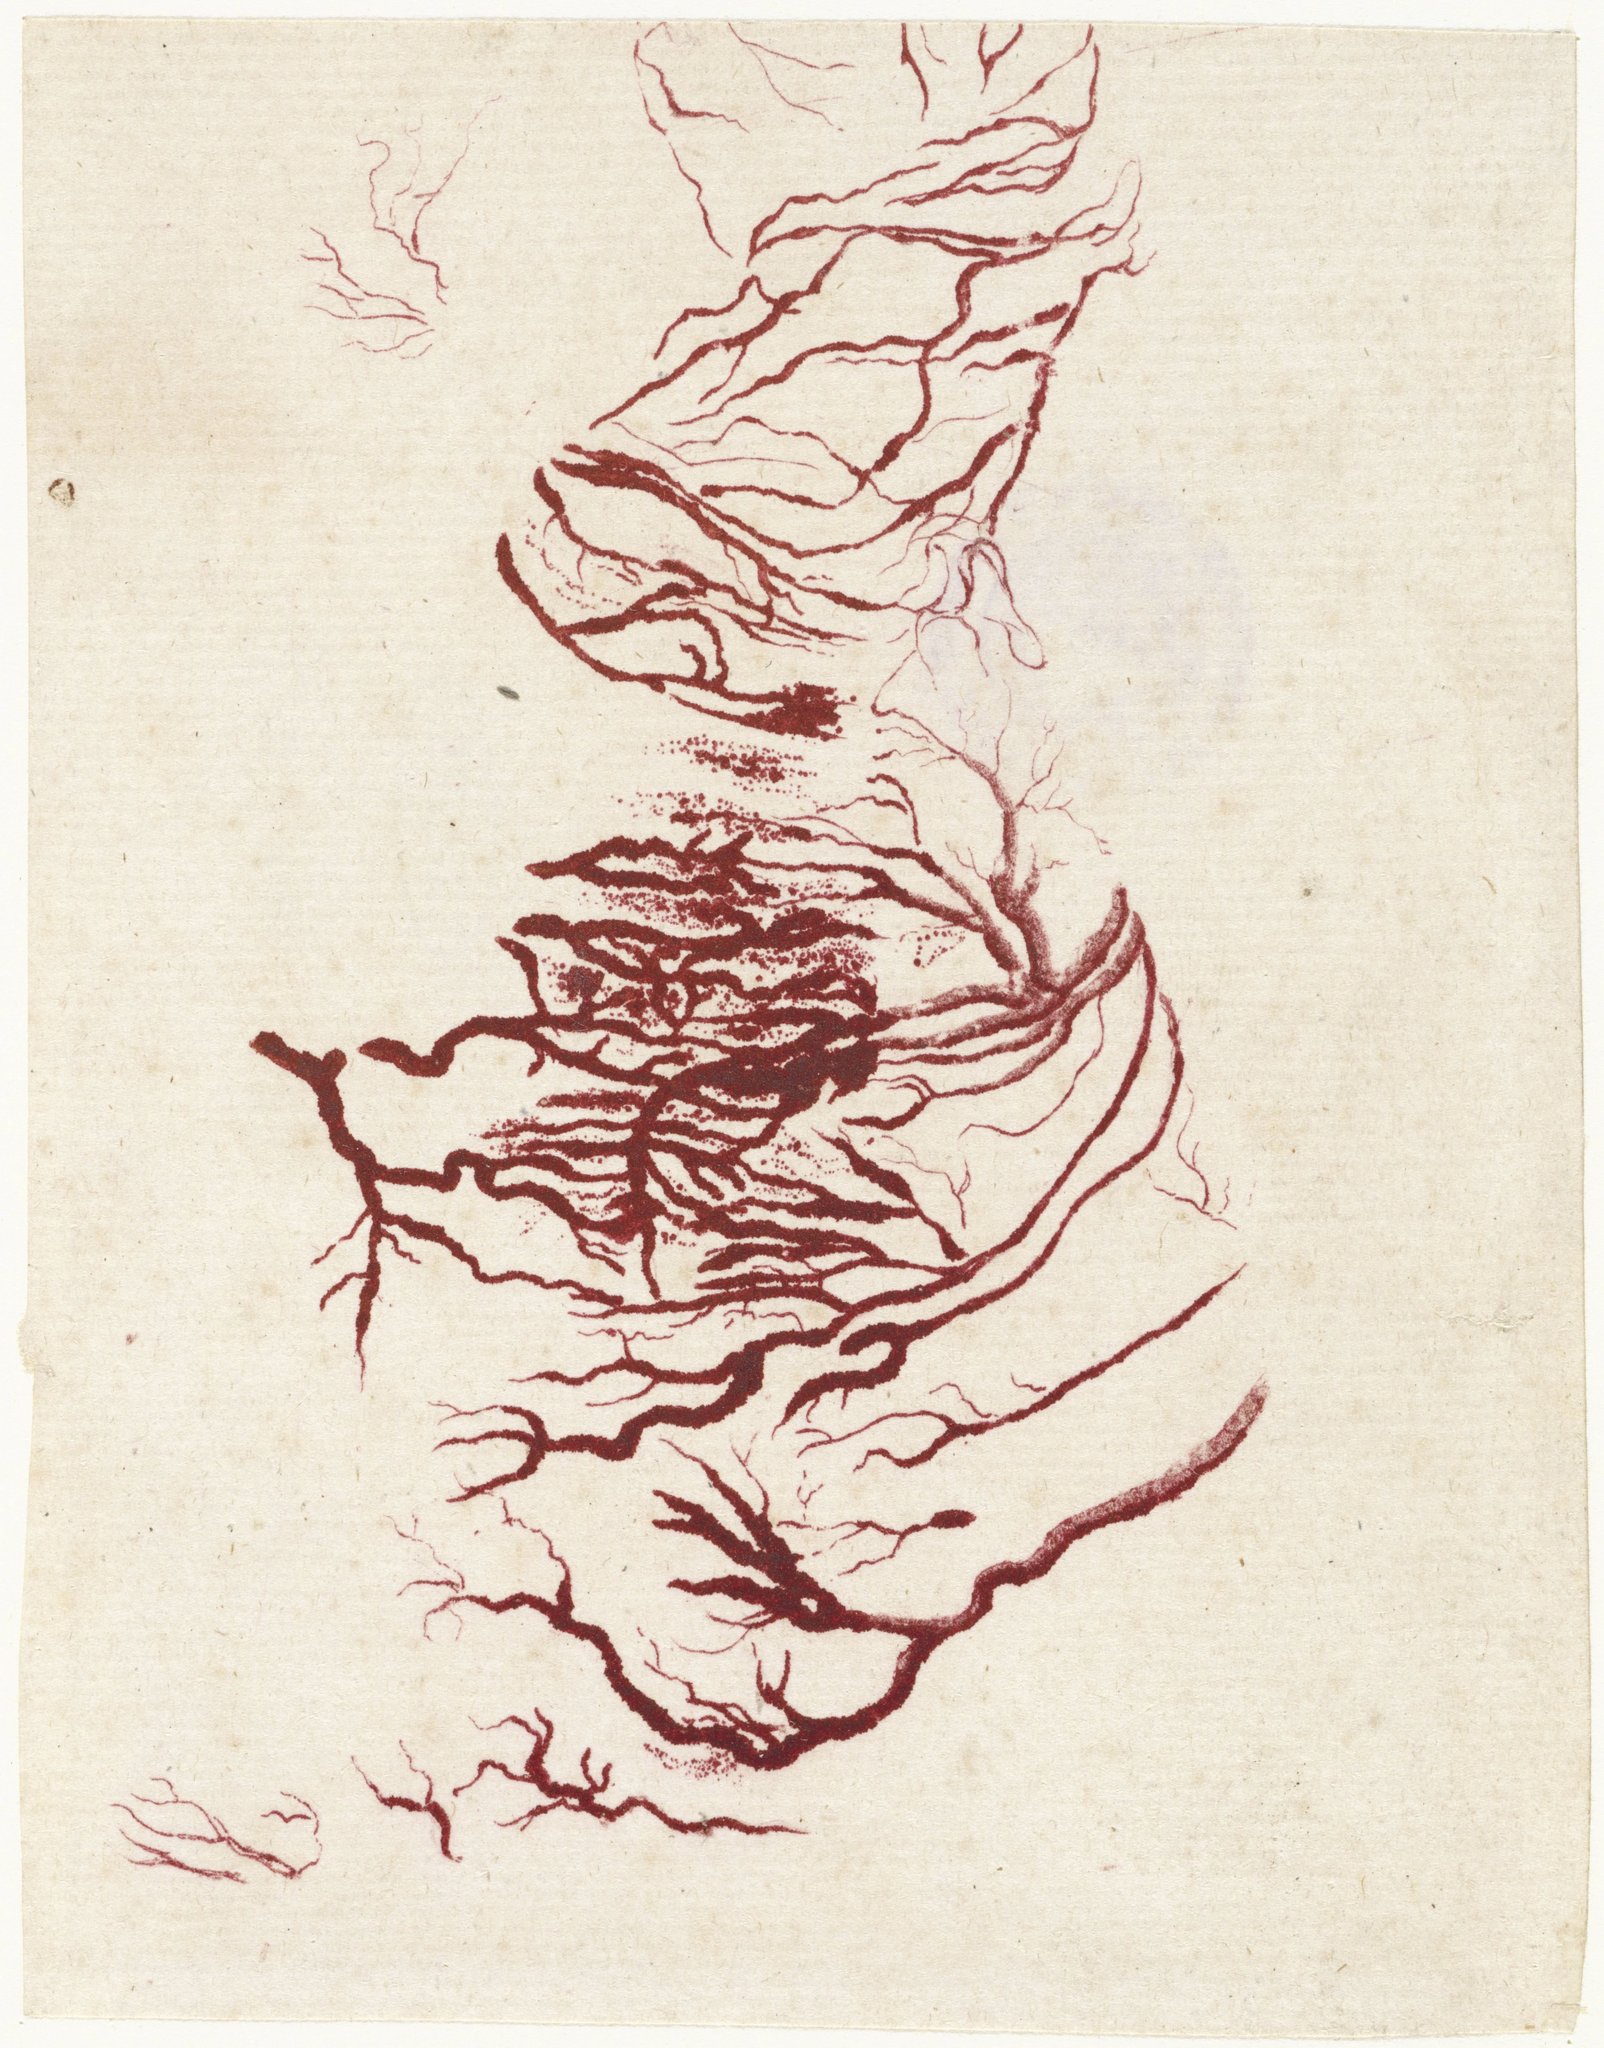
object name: print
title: Anatomische studie van een menselijk hart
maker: jan l admiral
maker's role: draughtsman, print maker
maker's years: 1699-1773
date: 1700-1750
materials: ink, paper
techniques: printmaking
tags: heart, other anatomical details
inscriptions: collector's mark: Lugt 2228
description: Jan L'Admiral gebruikte voor de groep mezzotinten met het onderwerp 'Anatomische studie van een menselijk hart' vijf verschillende platen: A, B, C, D en E.